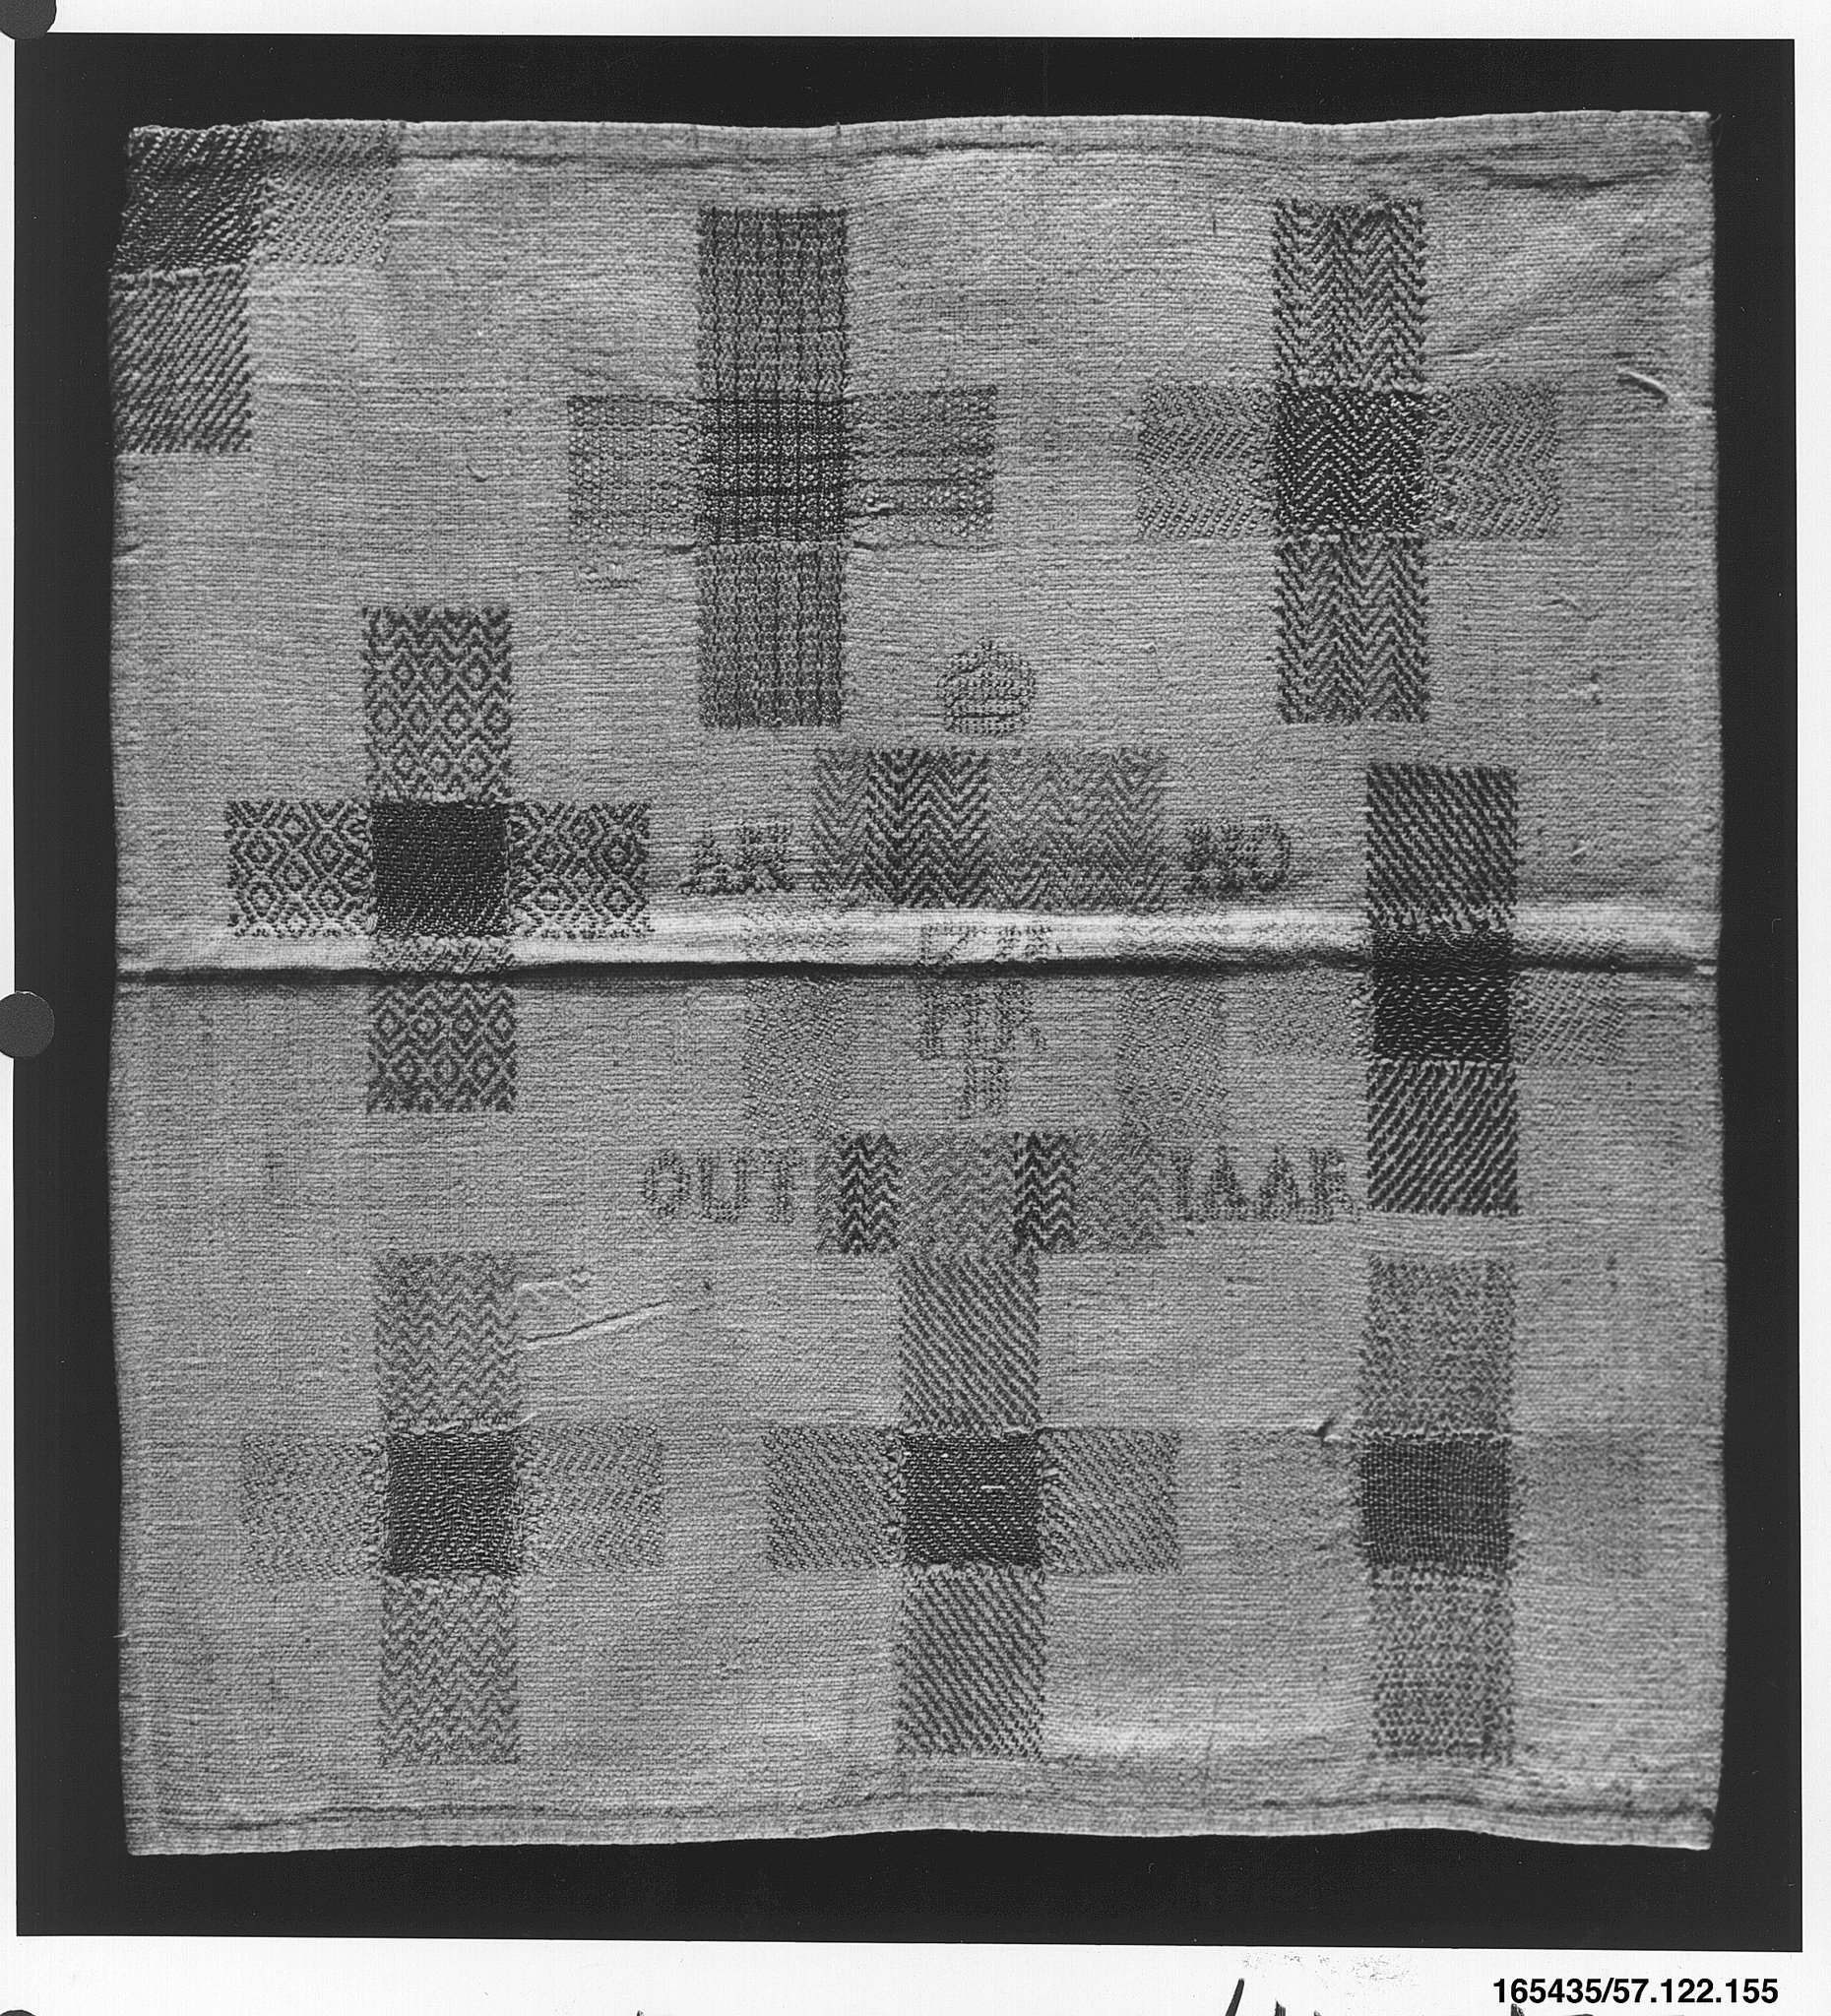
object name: sampler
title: Embroidered darning sampler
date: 1798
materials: cotton, silk